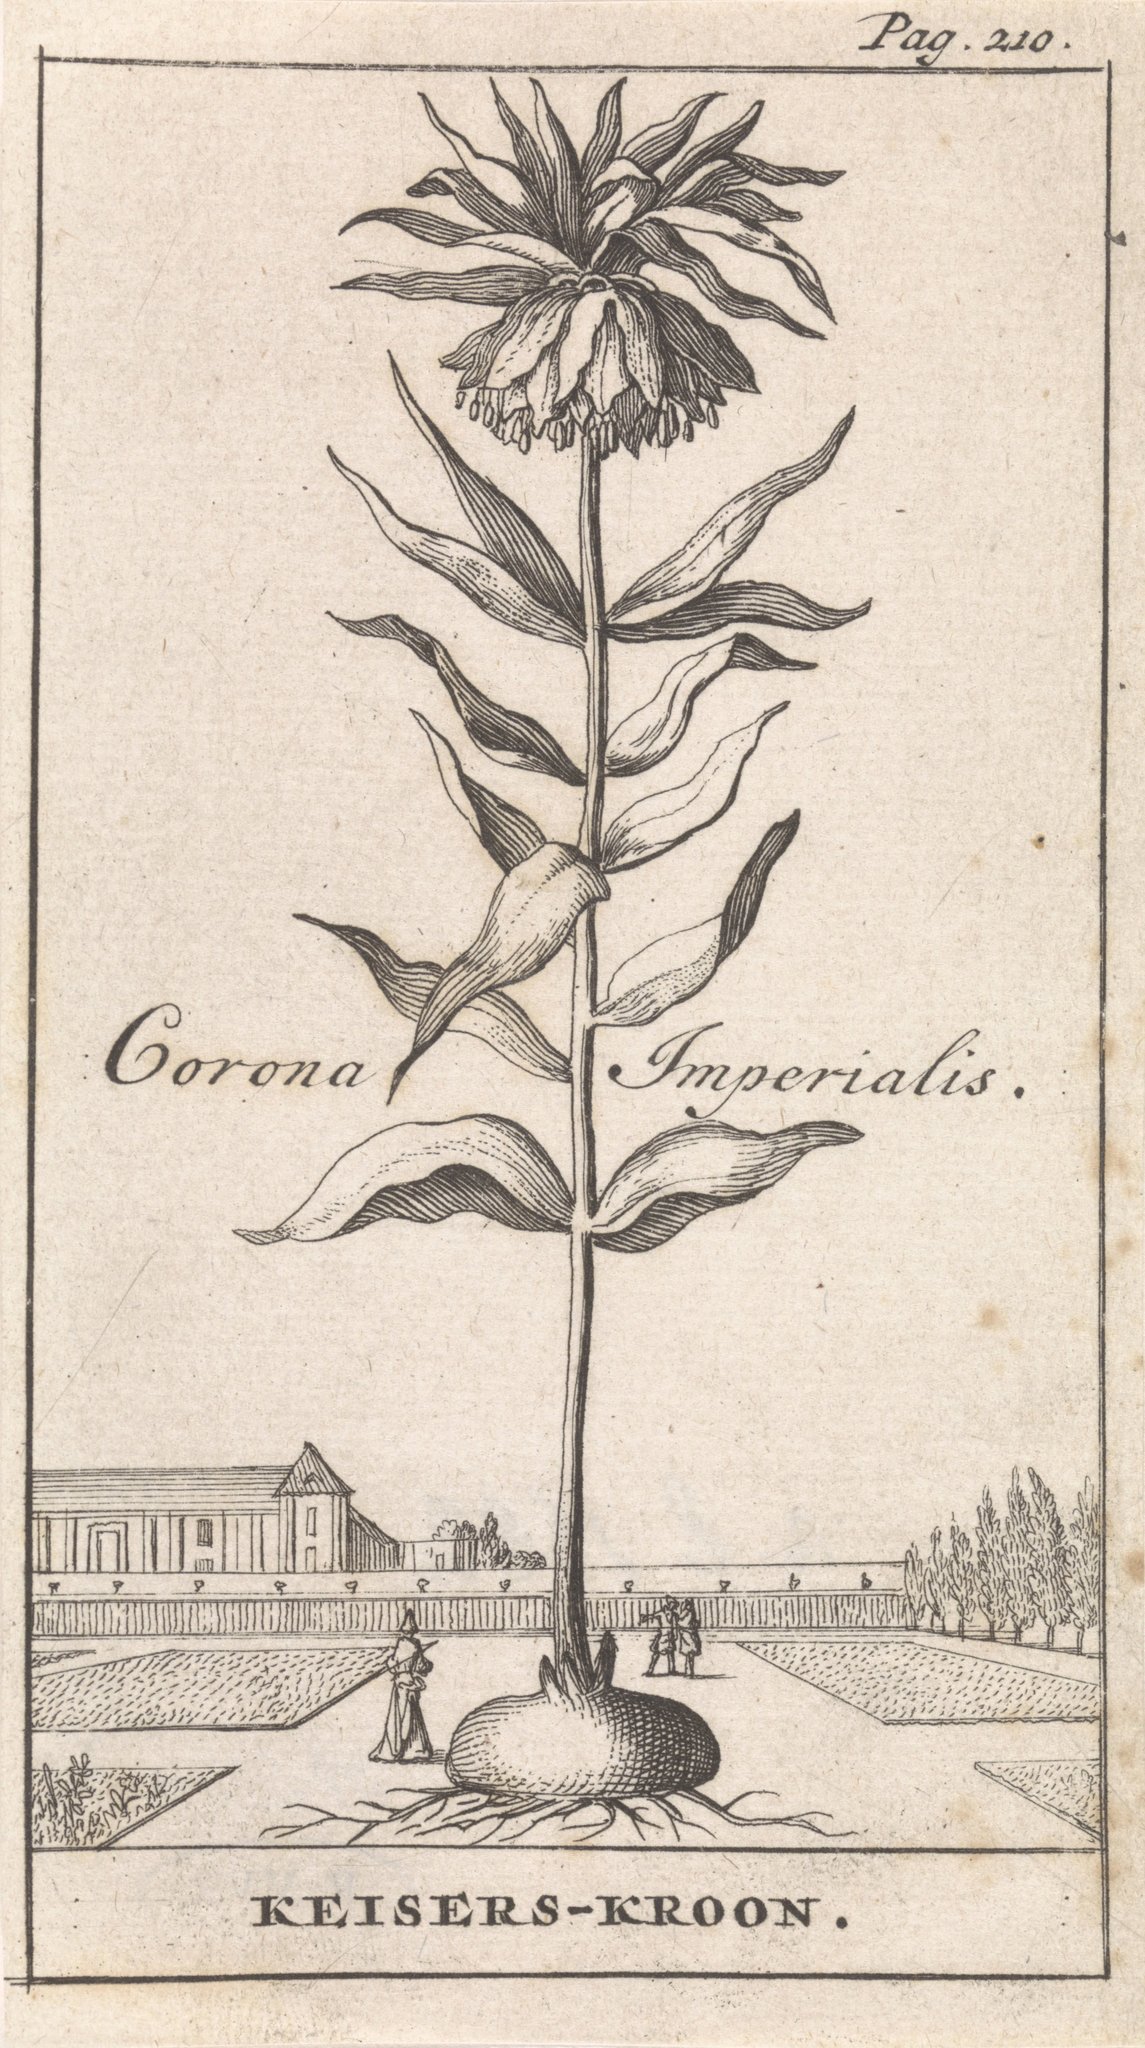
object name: book illustration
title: Keizerskroon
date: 1698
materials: paper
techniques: etching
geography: amsterdam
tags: plants and herbs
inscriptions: collector's mark: Lugt 2228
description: Illustratie uit: Blankaart, Steven. Den Neder-landschen herbarius ofte Kruid-boek der voornaamste kruiden. Amsterdam: Jan Claesz ten Hoorn, 1698.